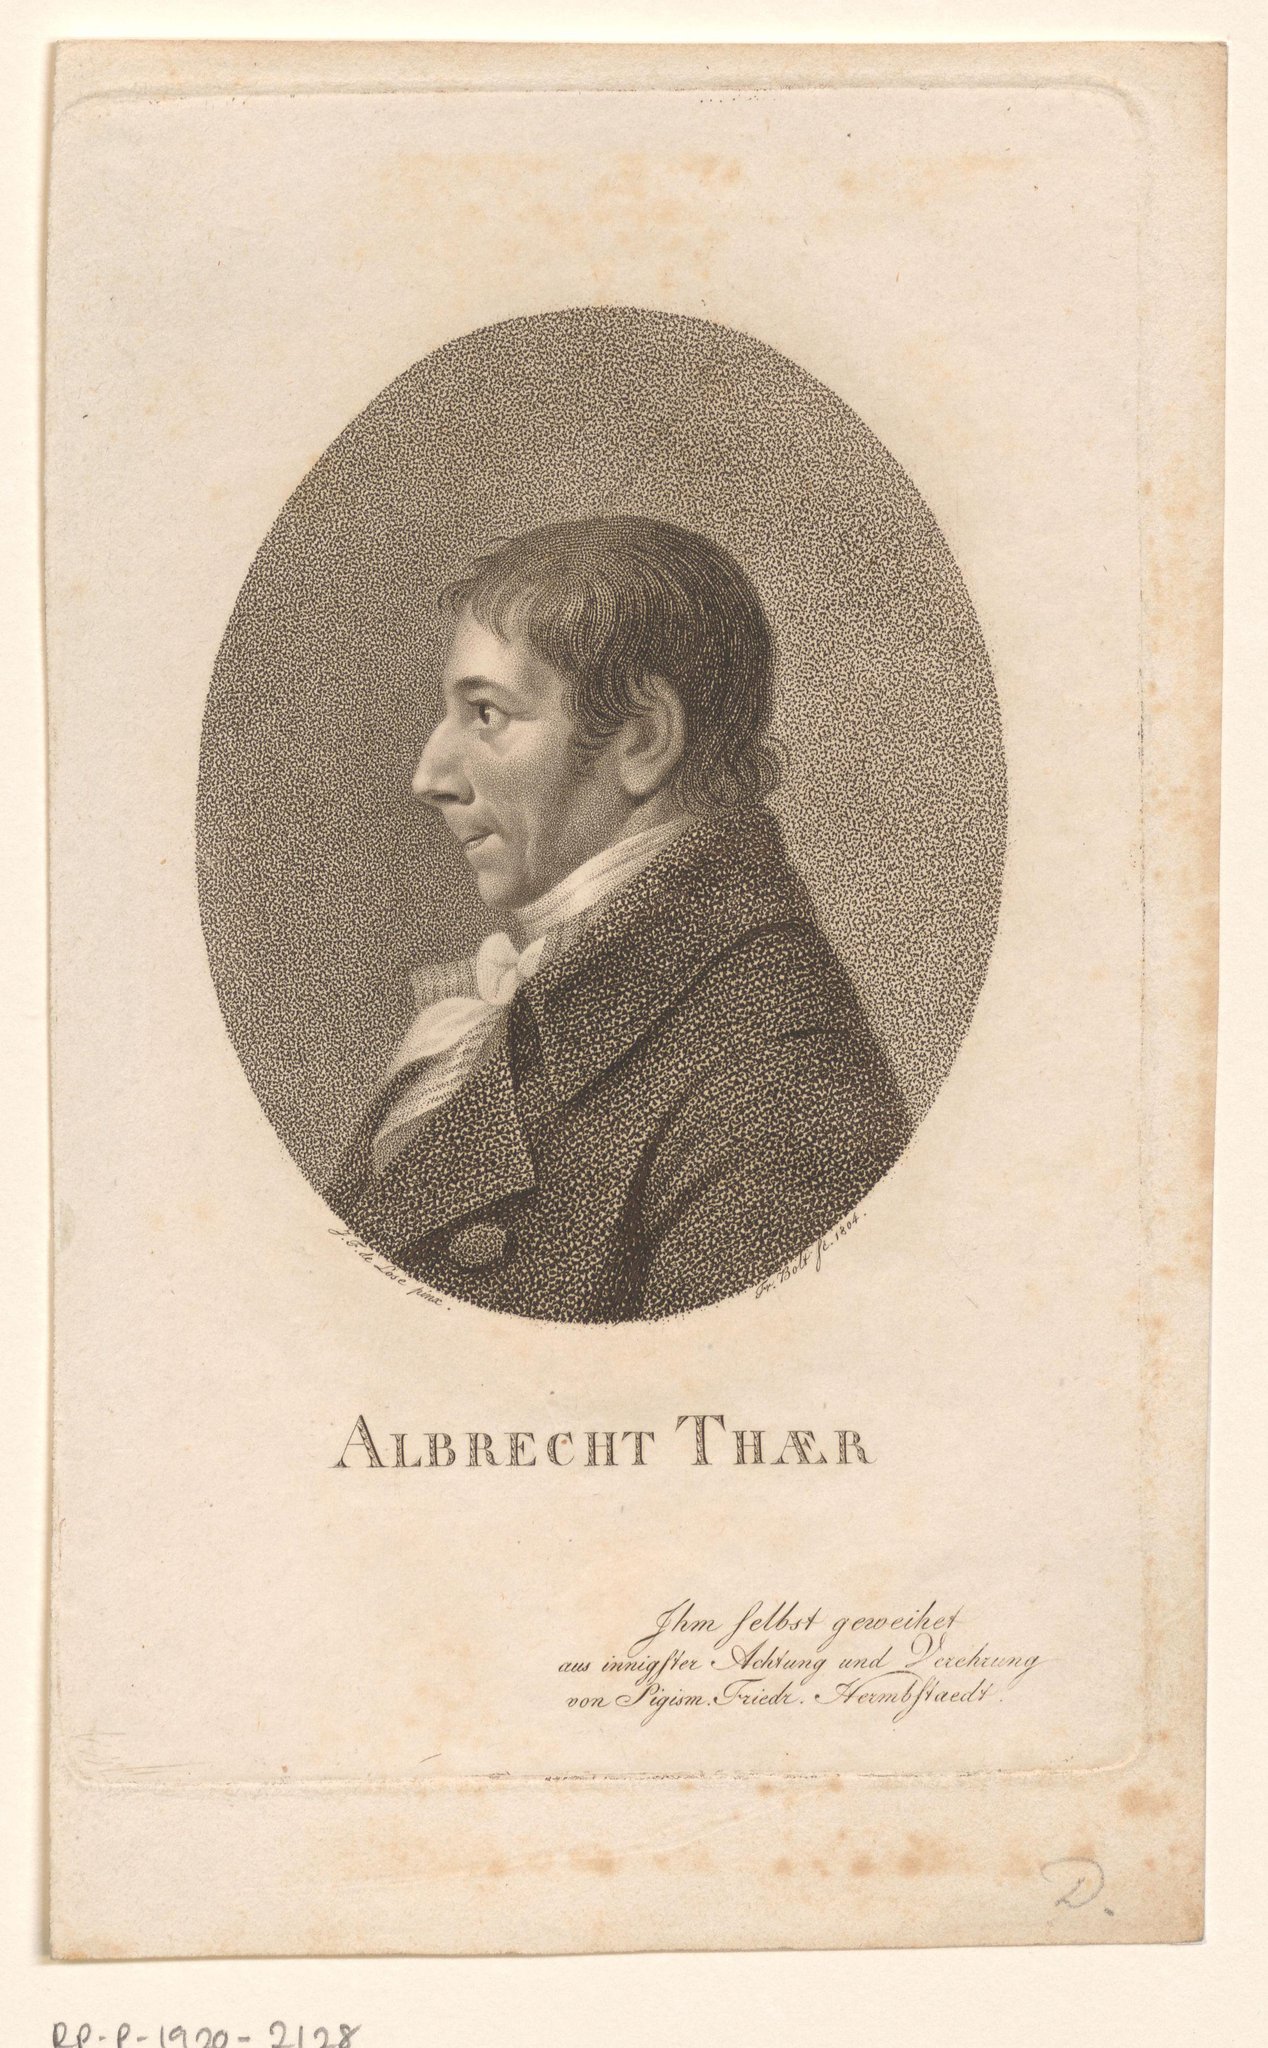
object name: print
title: Portret van Albrecht Daniel Thaer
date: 1804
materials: paper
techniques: engraving, etching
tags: albrecht daniel thaer, historical persons, physician, doctor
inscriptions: collector's mark: Lugt 2228